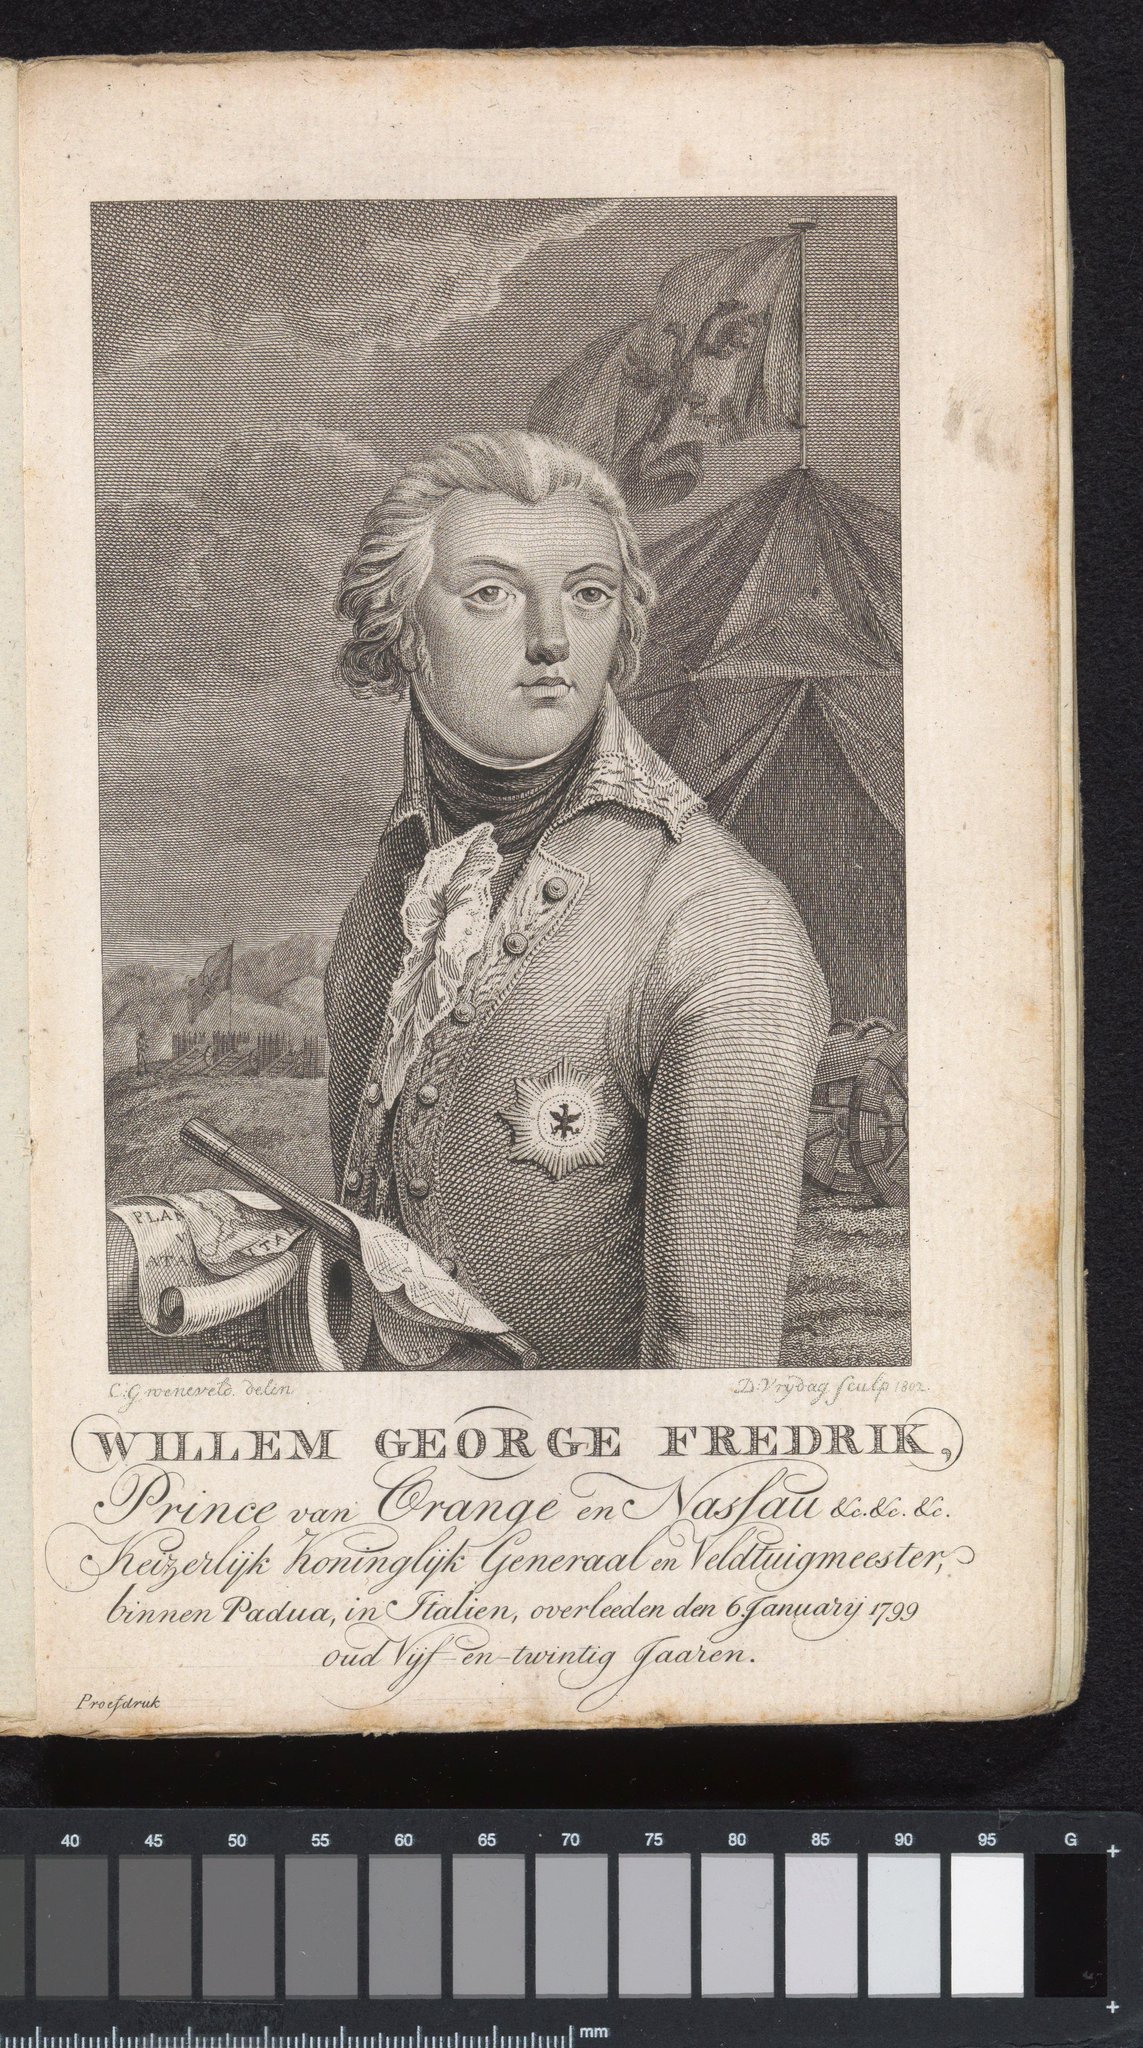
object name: print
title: Portret van Willem George Frederik, prins van Oranje-Nassau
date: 1802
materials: paper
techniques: engraving, etching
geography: netherlands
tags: the hague, willem george frederik (prins van oranje-nassau)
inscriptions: date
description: Portret van Willem George Frederik, prins van Oranje-Nassau. Op de achtergrond een Oostenrijks legerkamp. In de marge een vijfregelig onderschrift in het Nederlands. Illustratie in het vierdelige Leven van Willem George Fredrik (1802-1803).